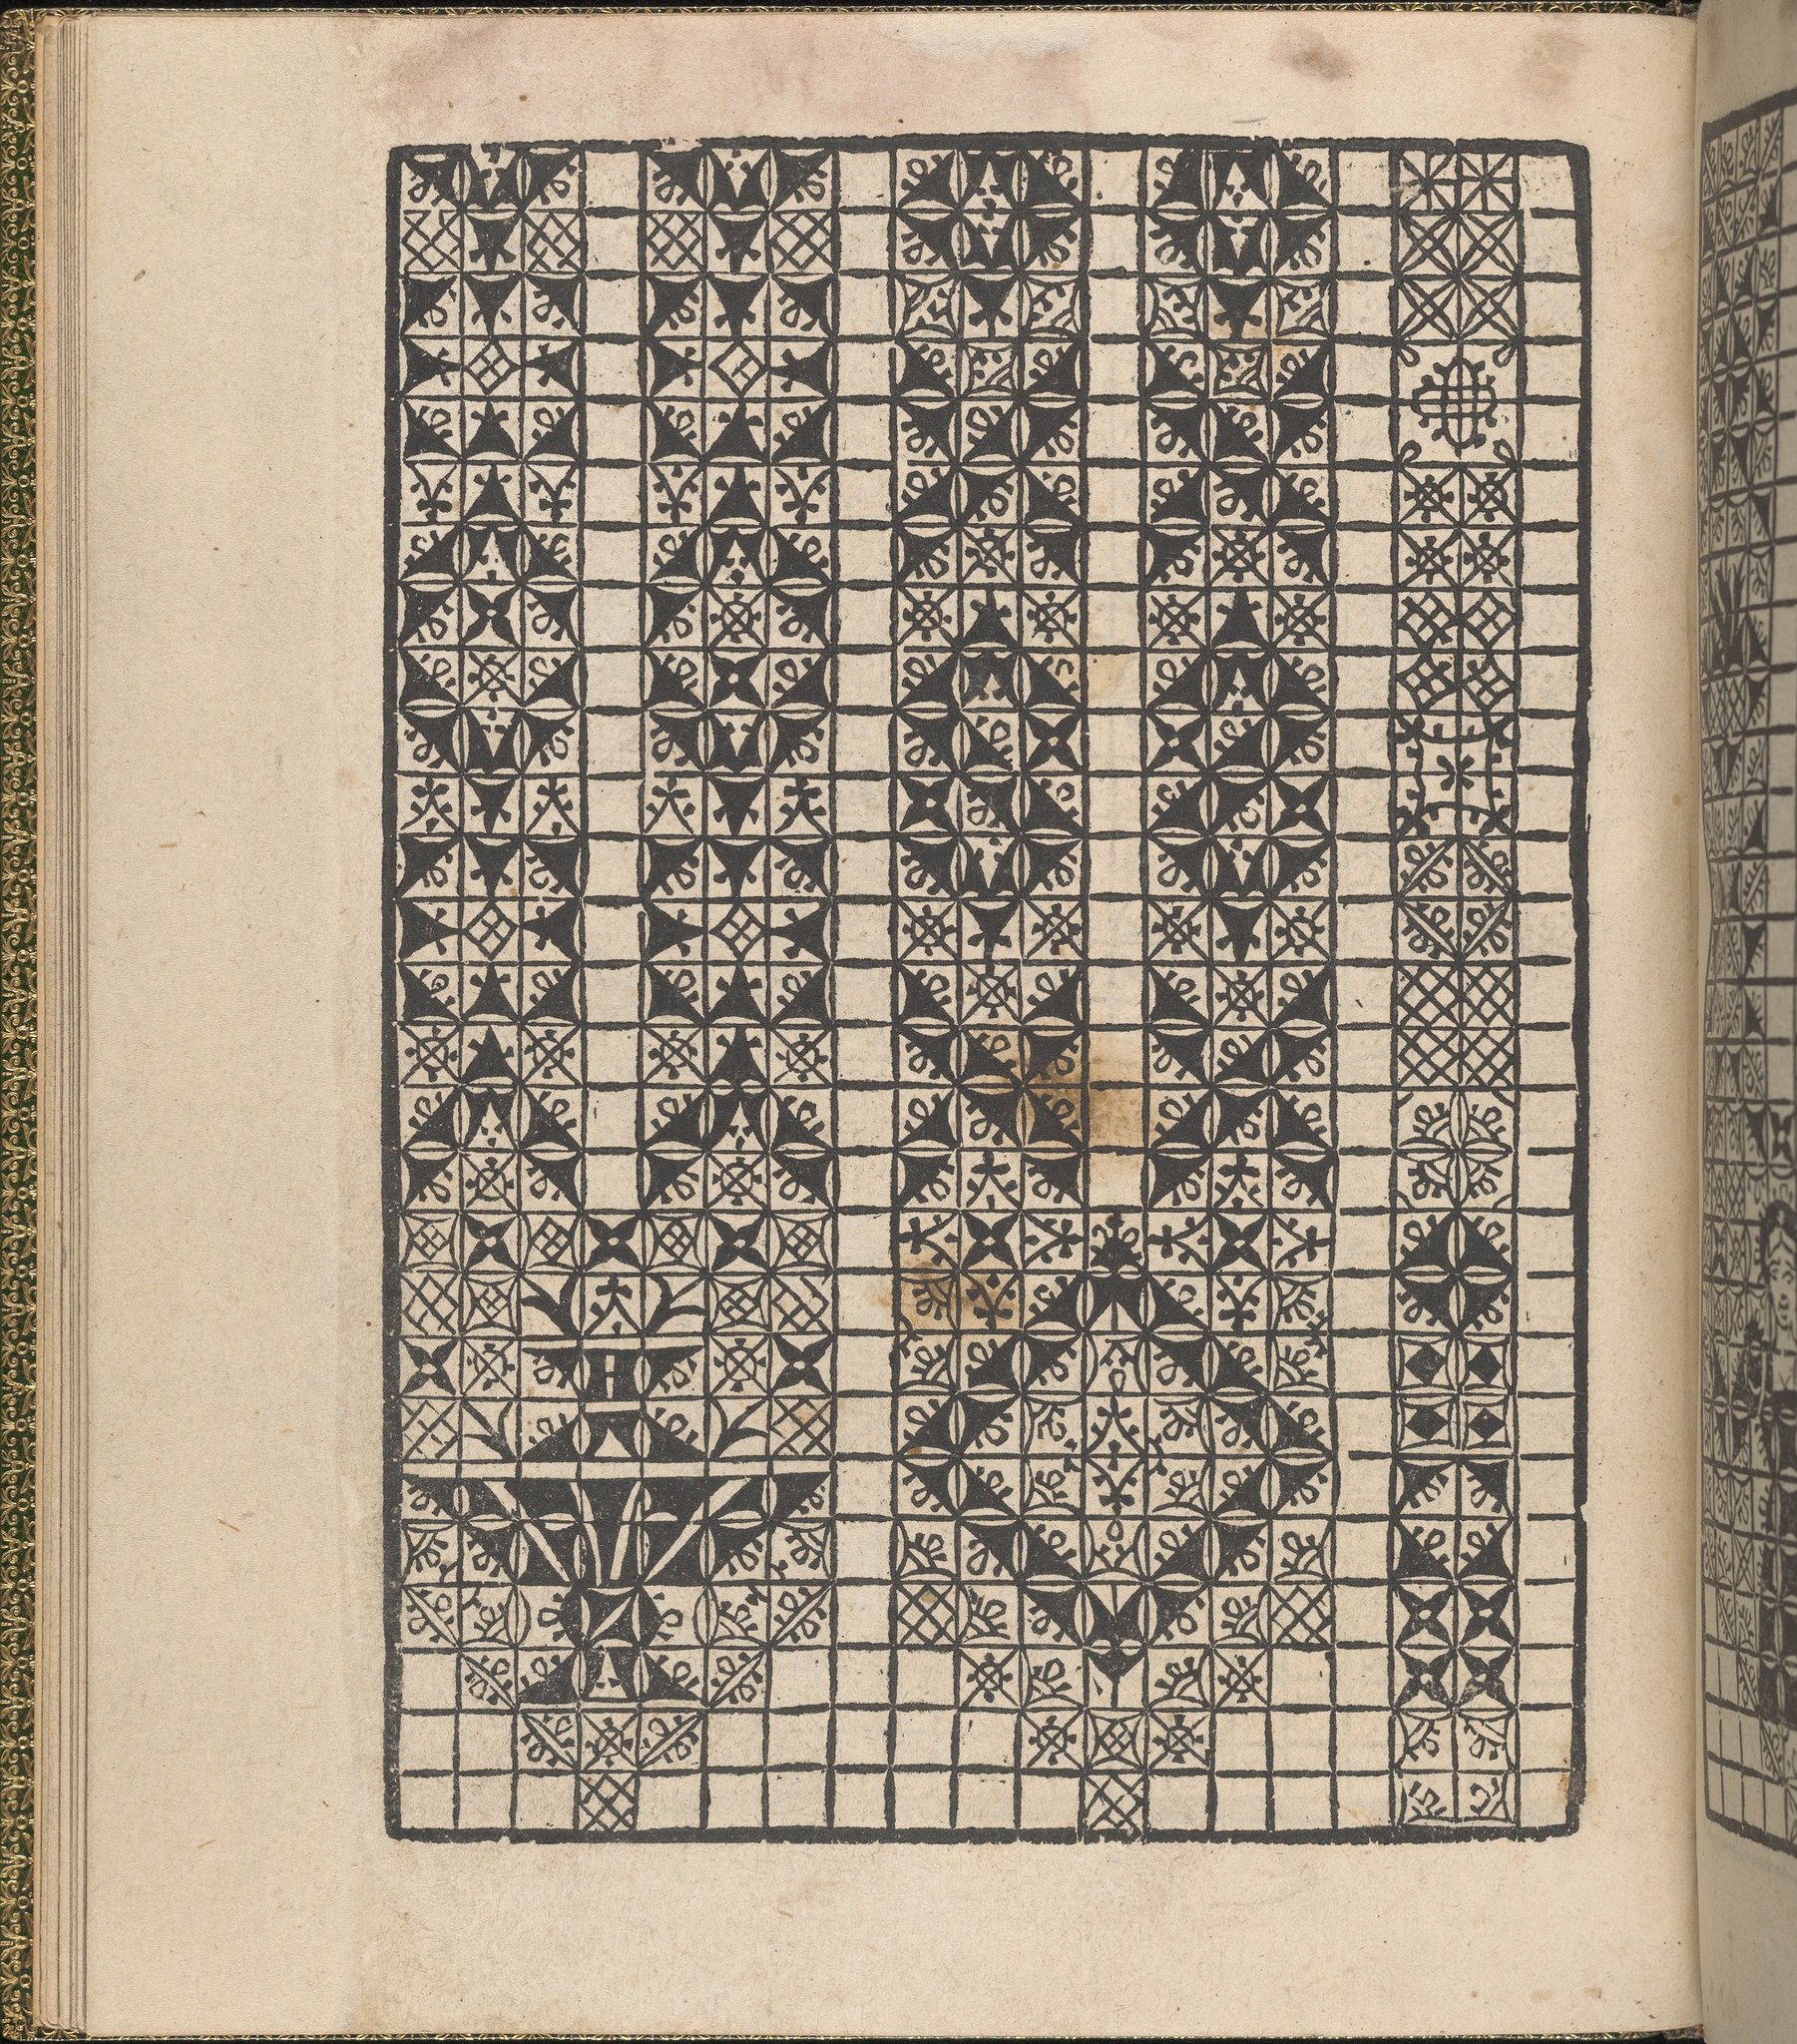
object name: book print ornament architecture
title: Giardineto novo di punti tagliati et gropposi per exercitio & ornamento delle donne (Venice 1554), page 15 (verso)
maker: matteo pagano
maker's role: publisher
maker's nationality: italian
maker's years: 1515-1588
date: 1554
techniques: woodcut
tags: ornament